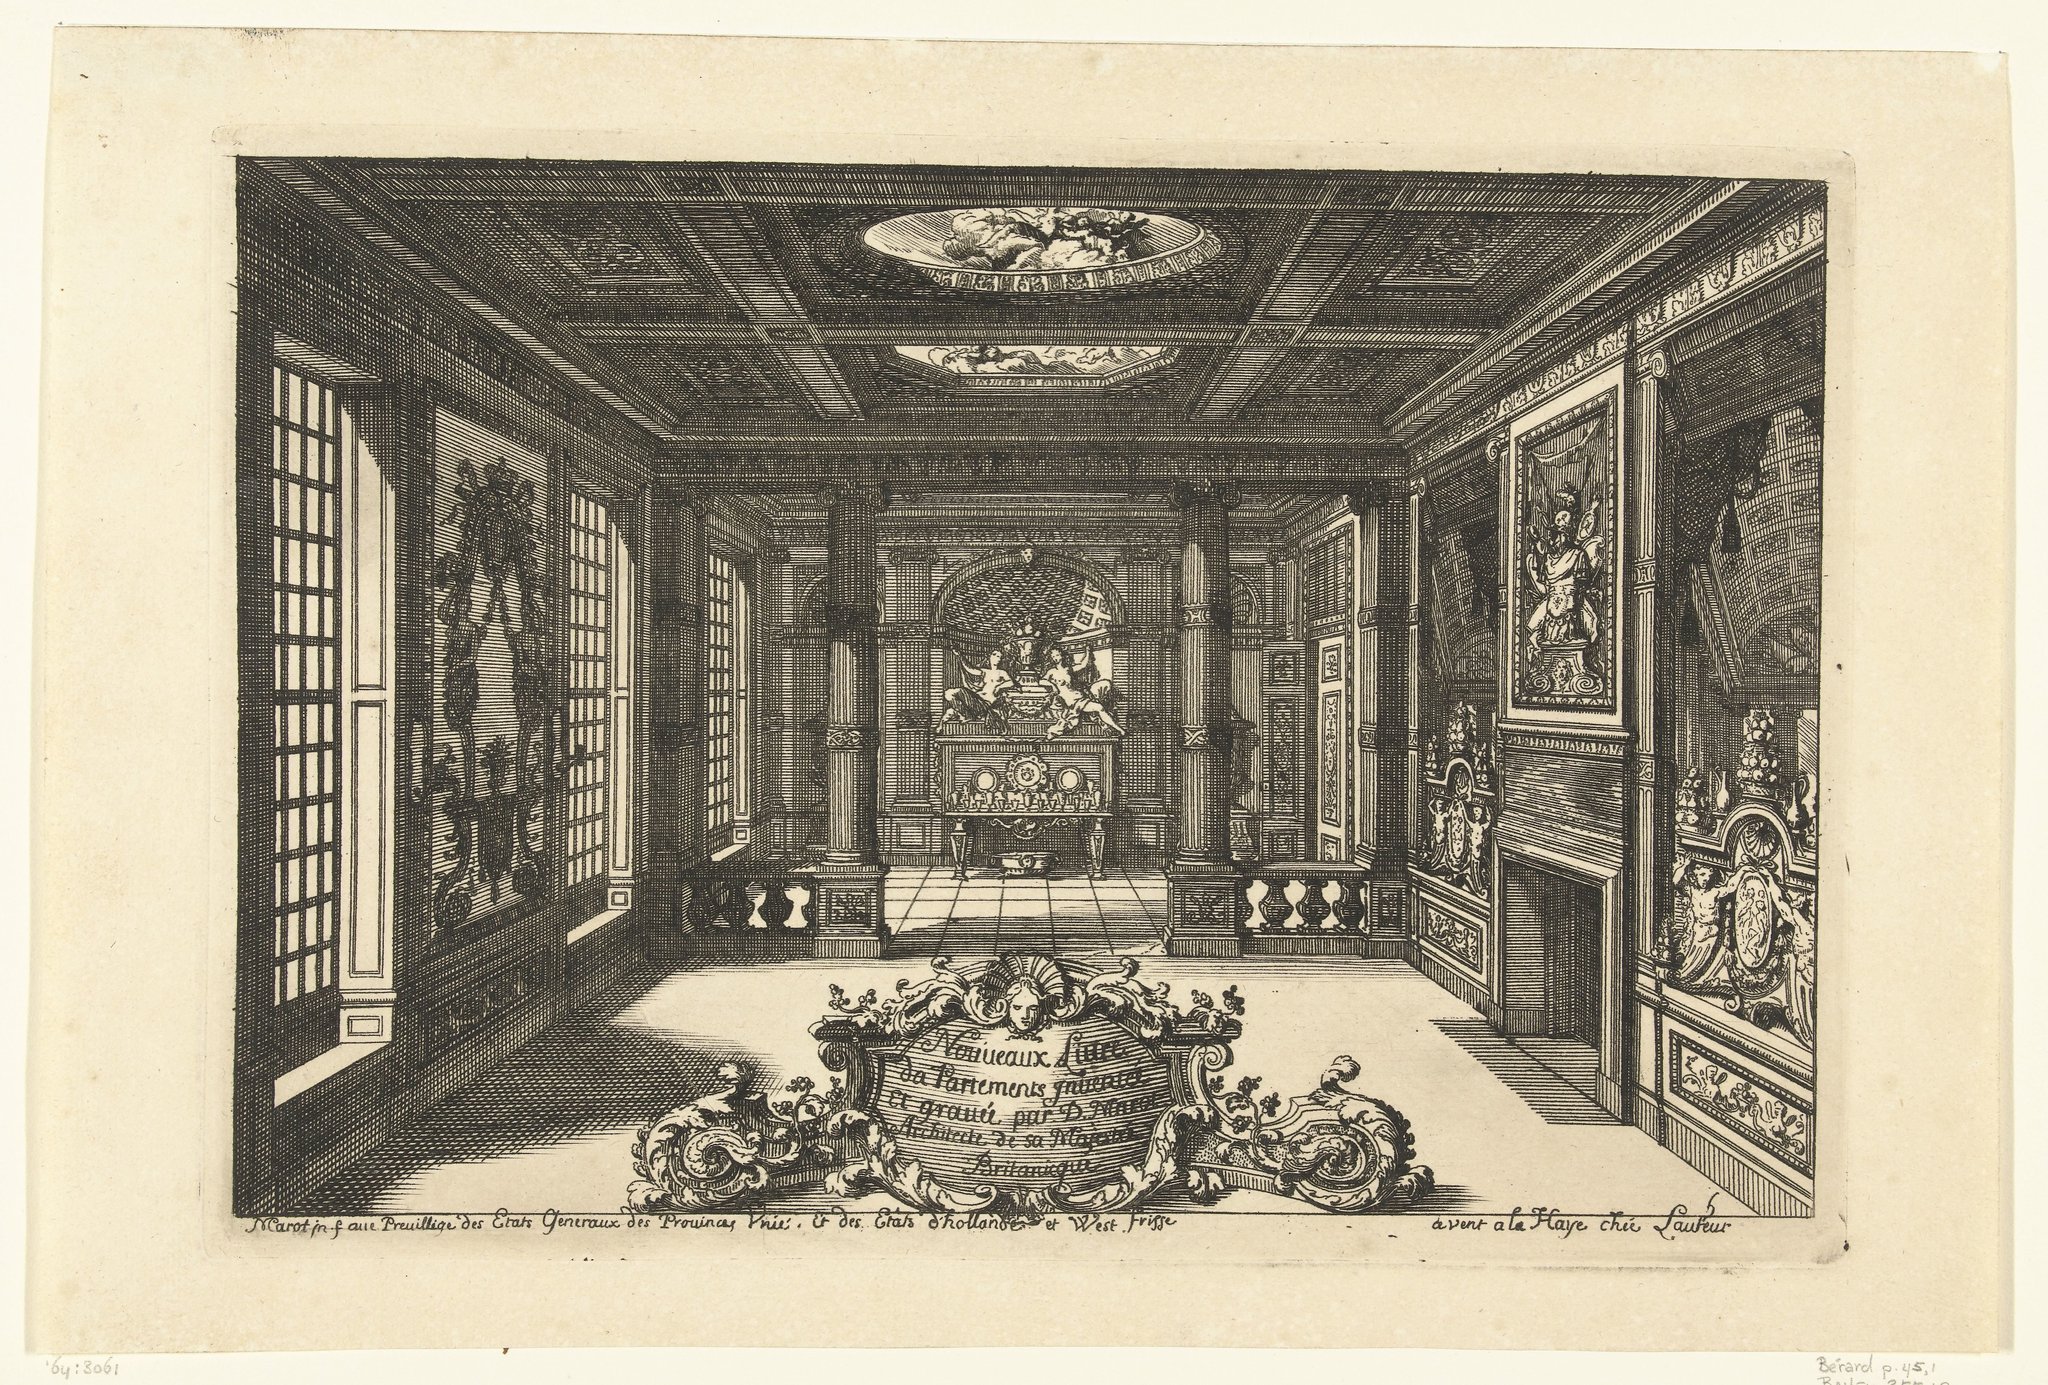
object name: ornament print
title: Nouveaux Livre da Partements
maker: daniël marot (i)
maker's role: draughtsman, print maker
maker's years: 1661-1752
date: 1712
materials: paper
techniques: etching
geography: netherlands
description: Interieur verdeeld in twee delen door een balustrade en Ionische zuilen. Links bevinden zich drie ramen. Uit serie van 6 bladen.